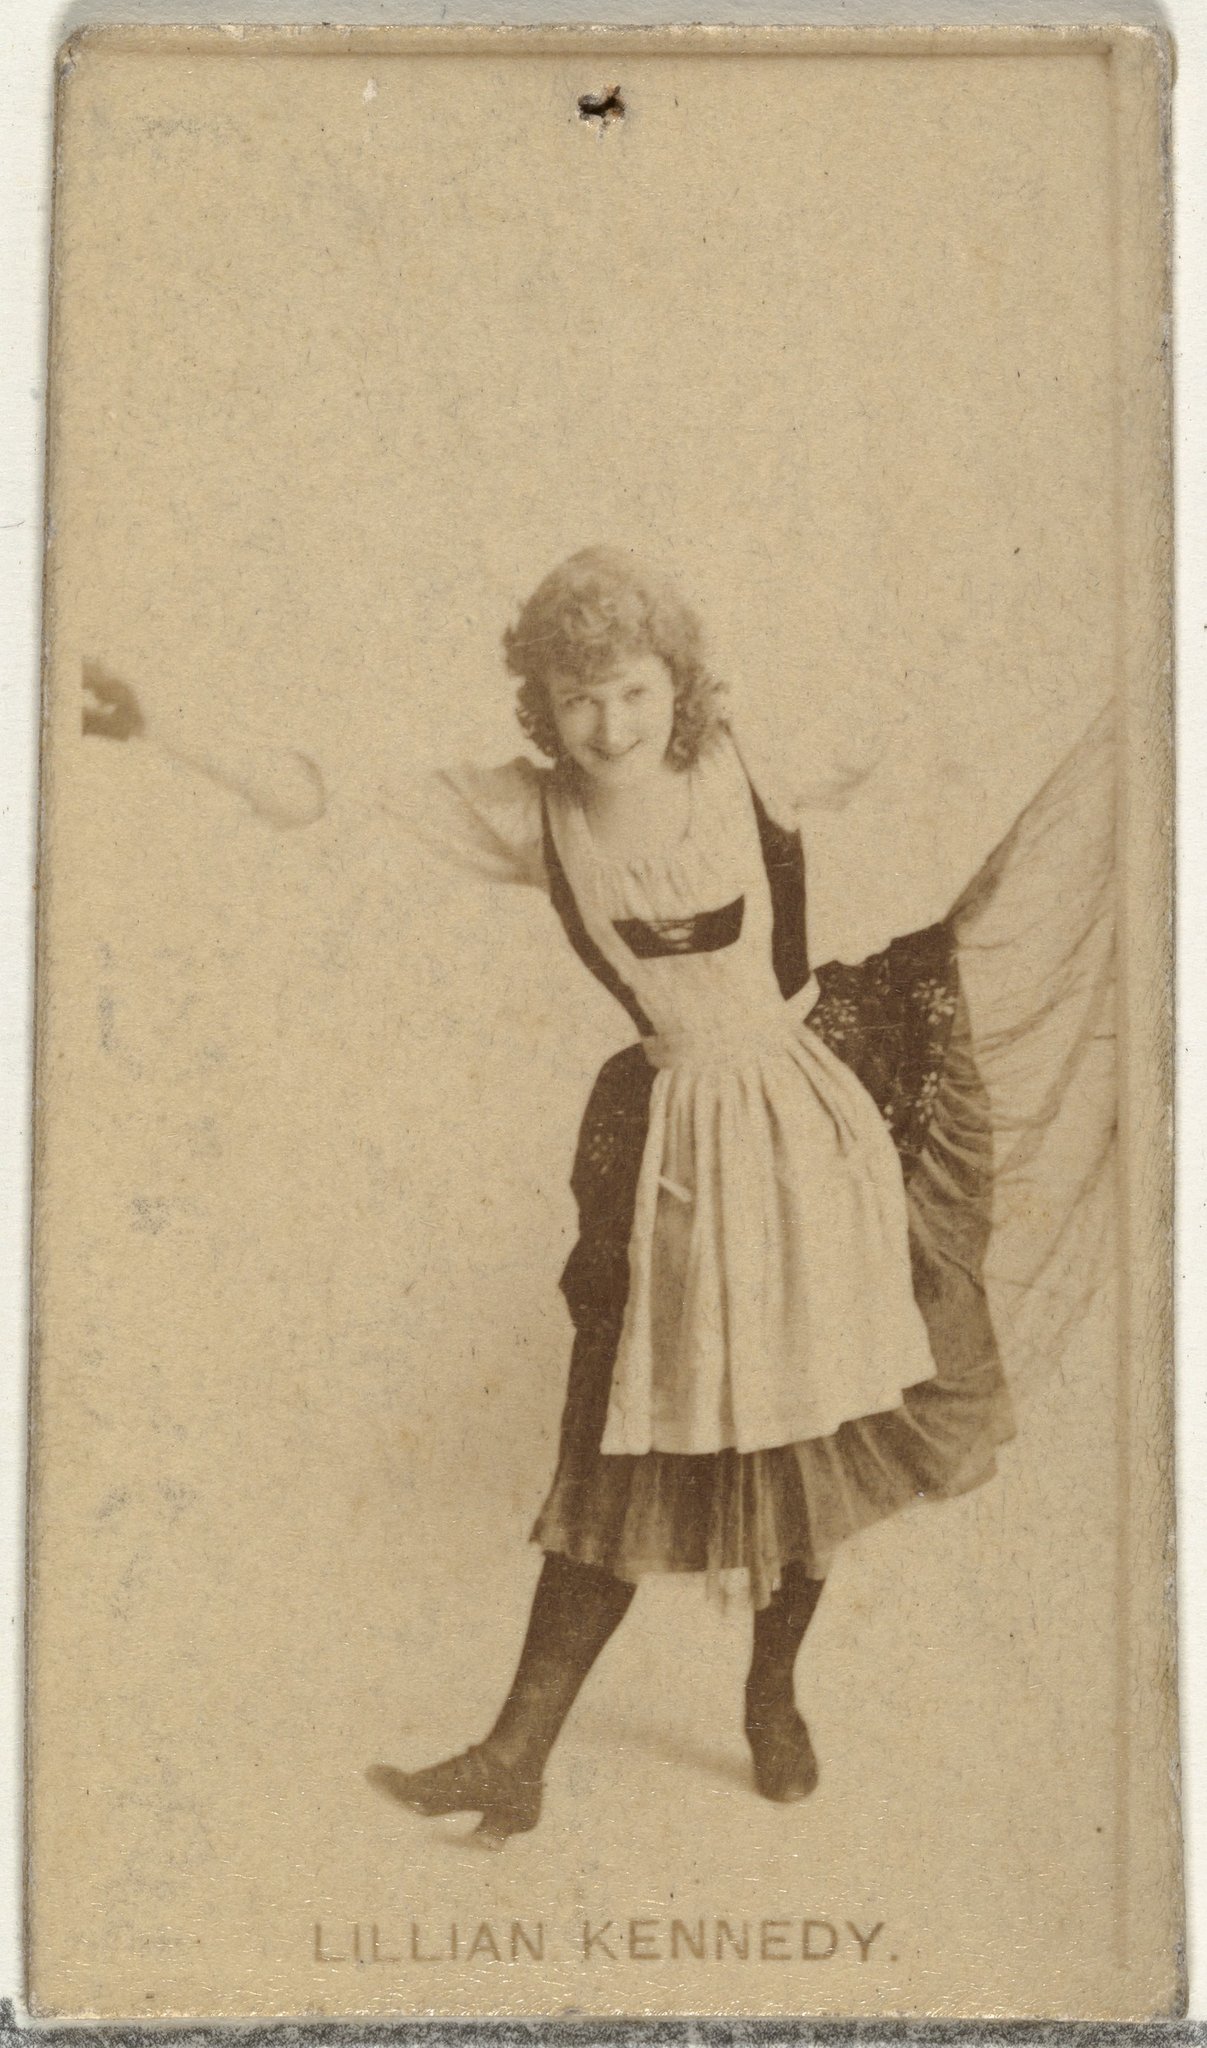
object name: photograph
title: Lillian Kennedy, from the Actors and Actresses series (N145-8) issued by Duke Sons & Co. to promote Duke Cigarettes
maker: w. duke, sons & co.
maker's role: publisher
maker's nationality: american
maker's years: 1870-1920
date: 1891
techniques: albumen silver print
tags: portraits,women,actresses